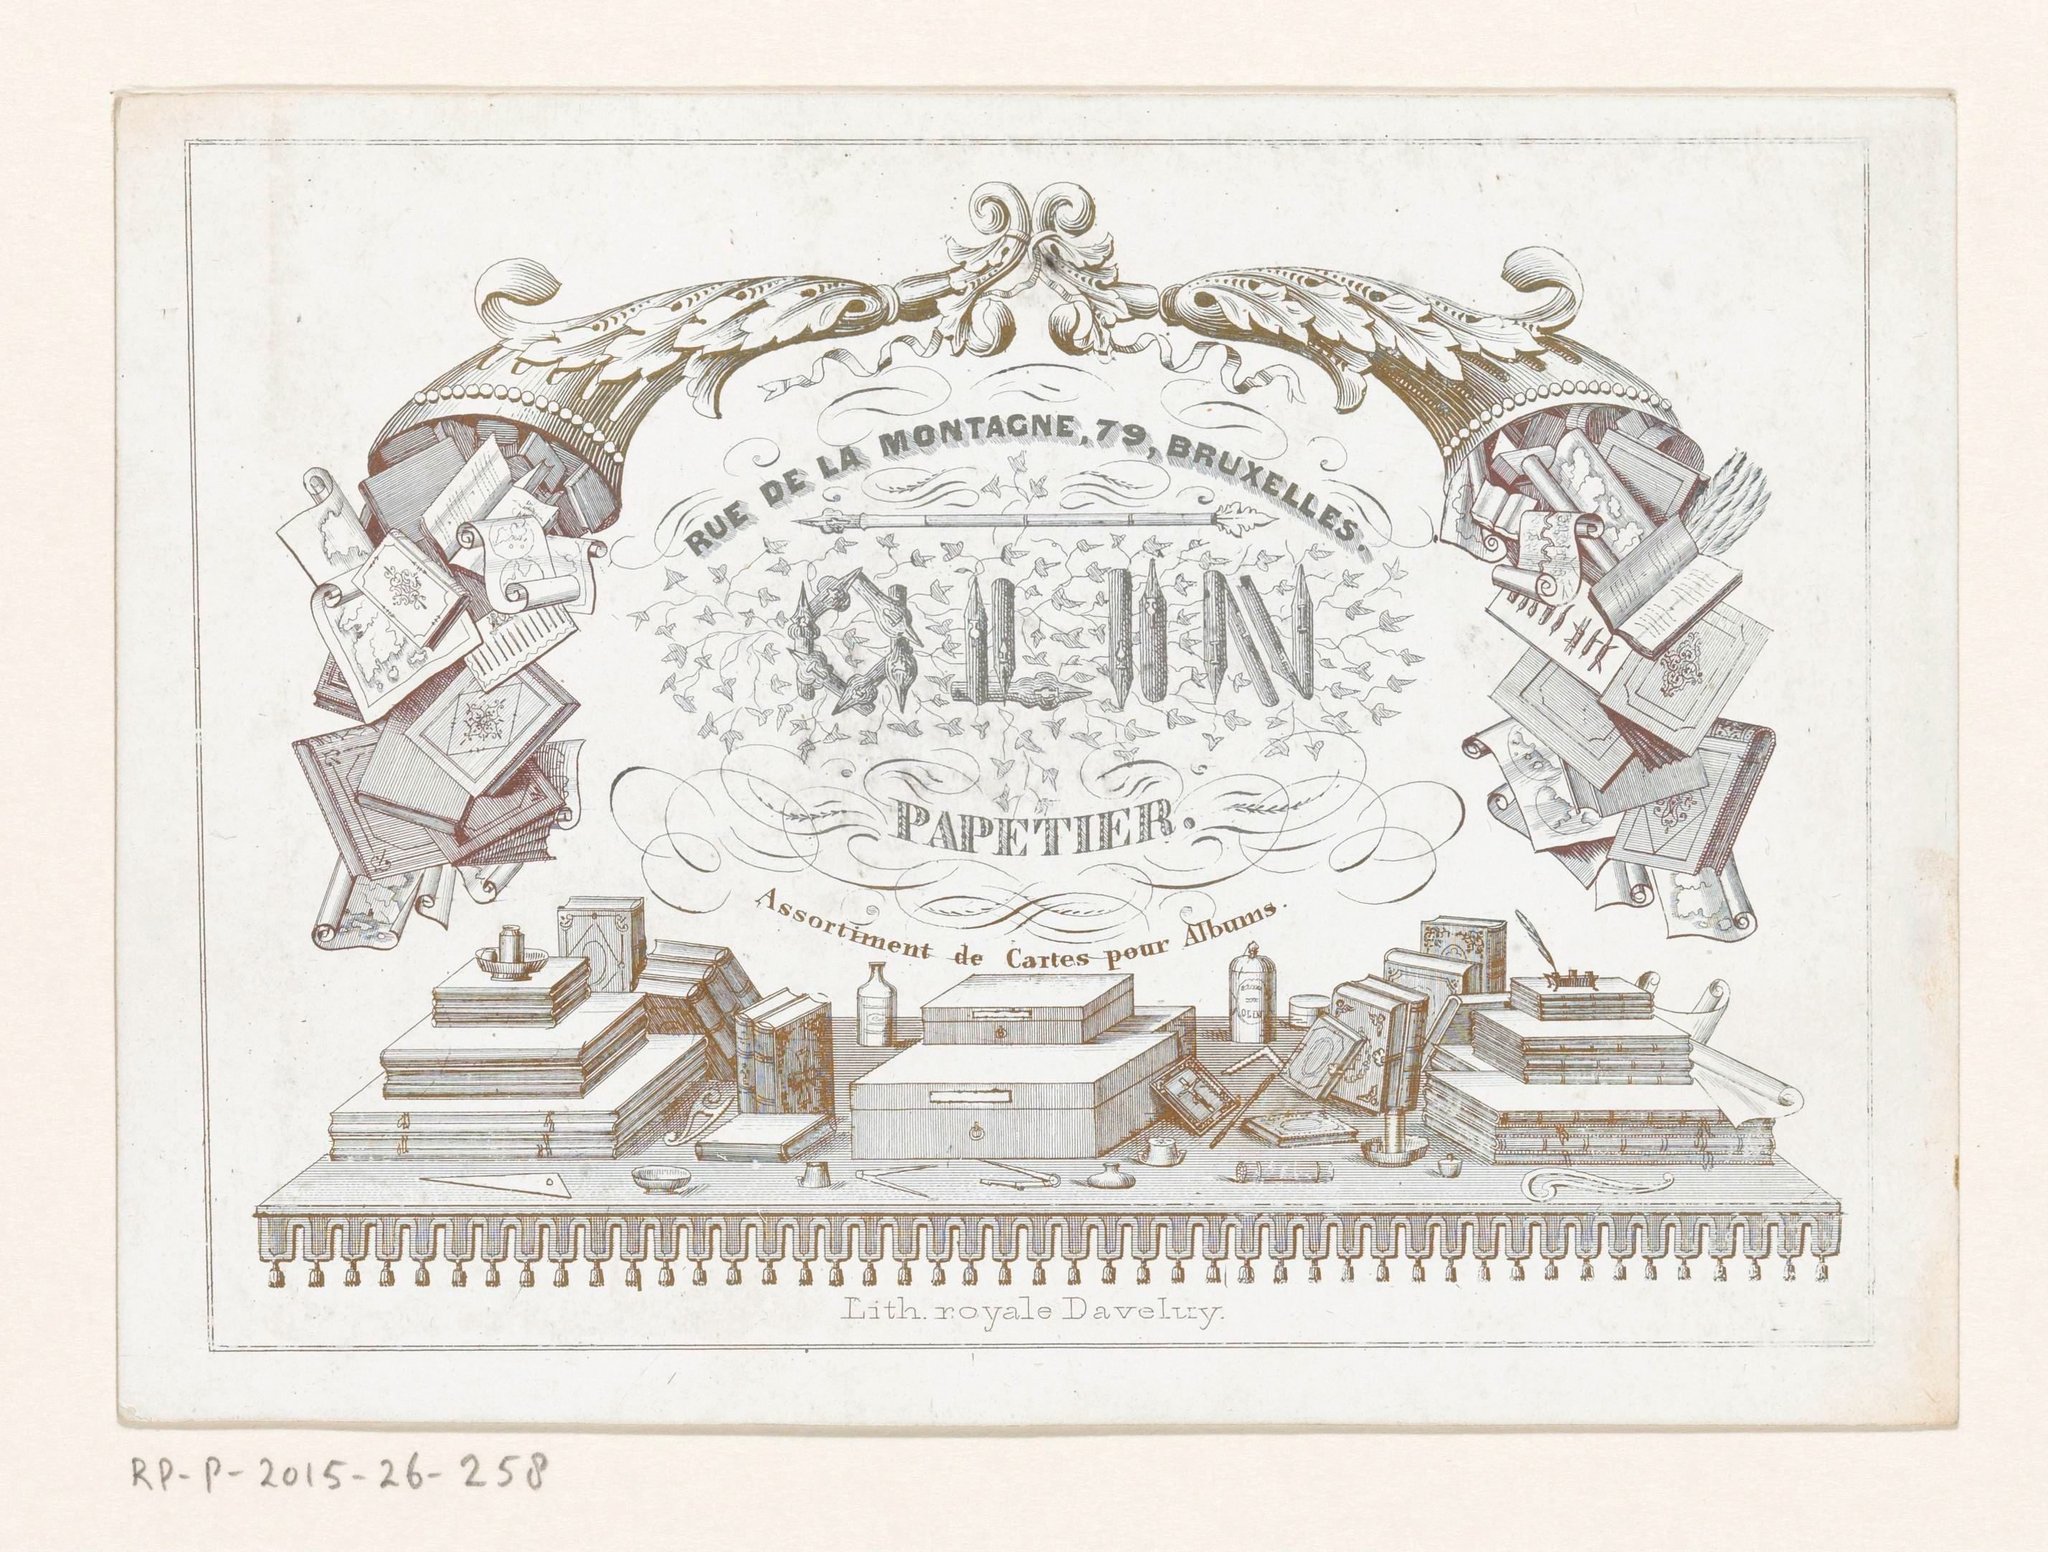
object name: print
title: Visitekaartje van papierhandel Olin te Brussel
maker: edouard-alexis daveluy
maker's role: print maker, printer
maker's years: 1812-1894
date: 1842-1894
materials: porcelainized cardboard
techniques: lithograph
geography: bruges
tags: 'cornucopia', horn of plenty, print, e.g.: engraving, etching, lithograph, book, paper (writing material)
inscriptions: collector's mark: Lugt 2228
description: Onder de naam van de firma, opgebouwd uit kroontjespennen, een tafel met katernen, boekbanden en teken- en schrijfattributen. Aan beide zijden een Hoorn des overvloeds waaruit boeken en prenten vallen.